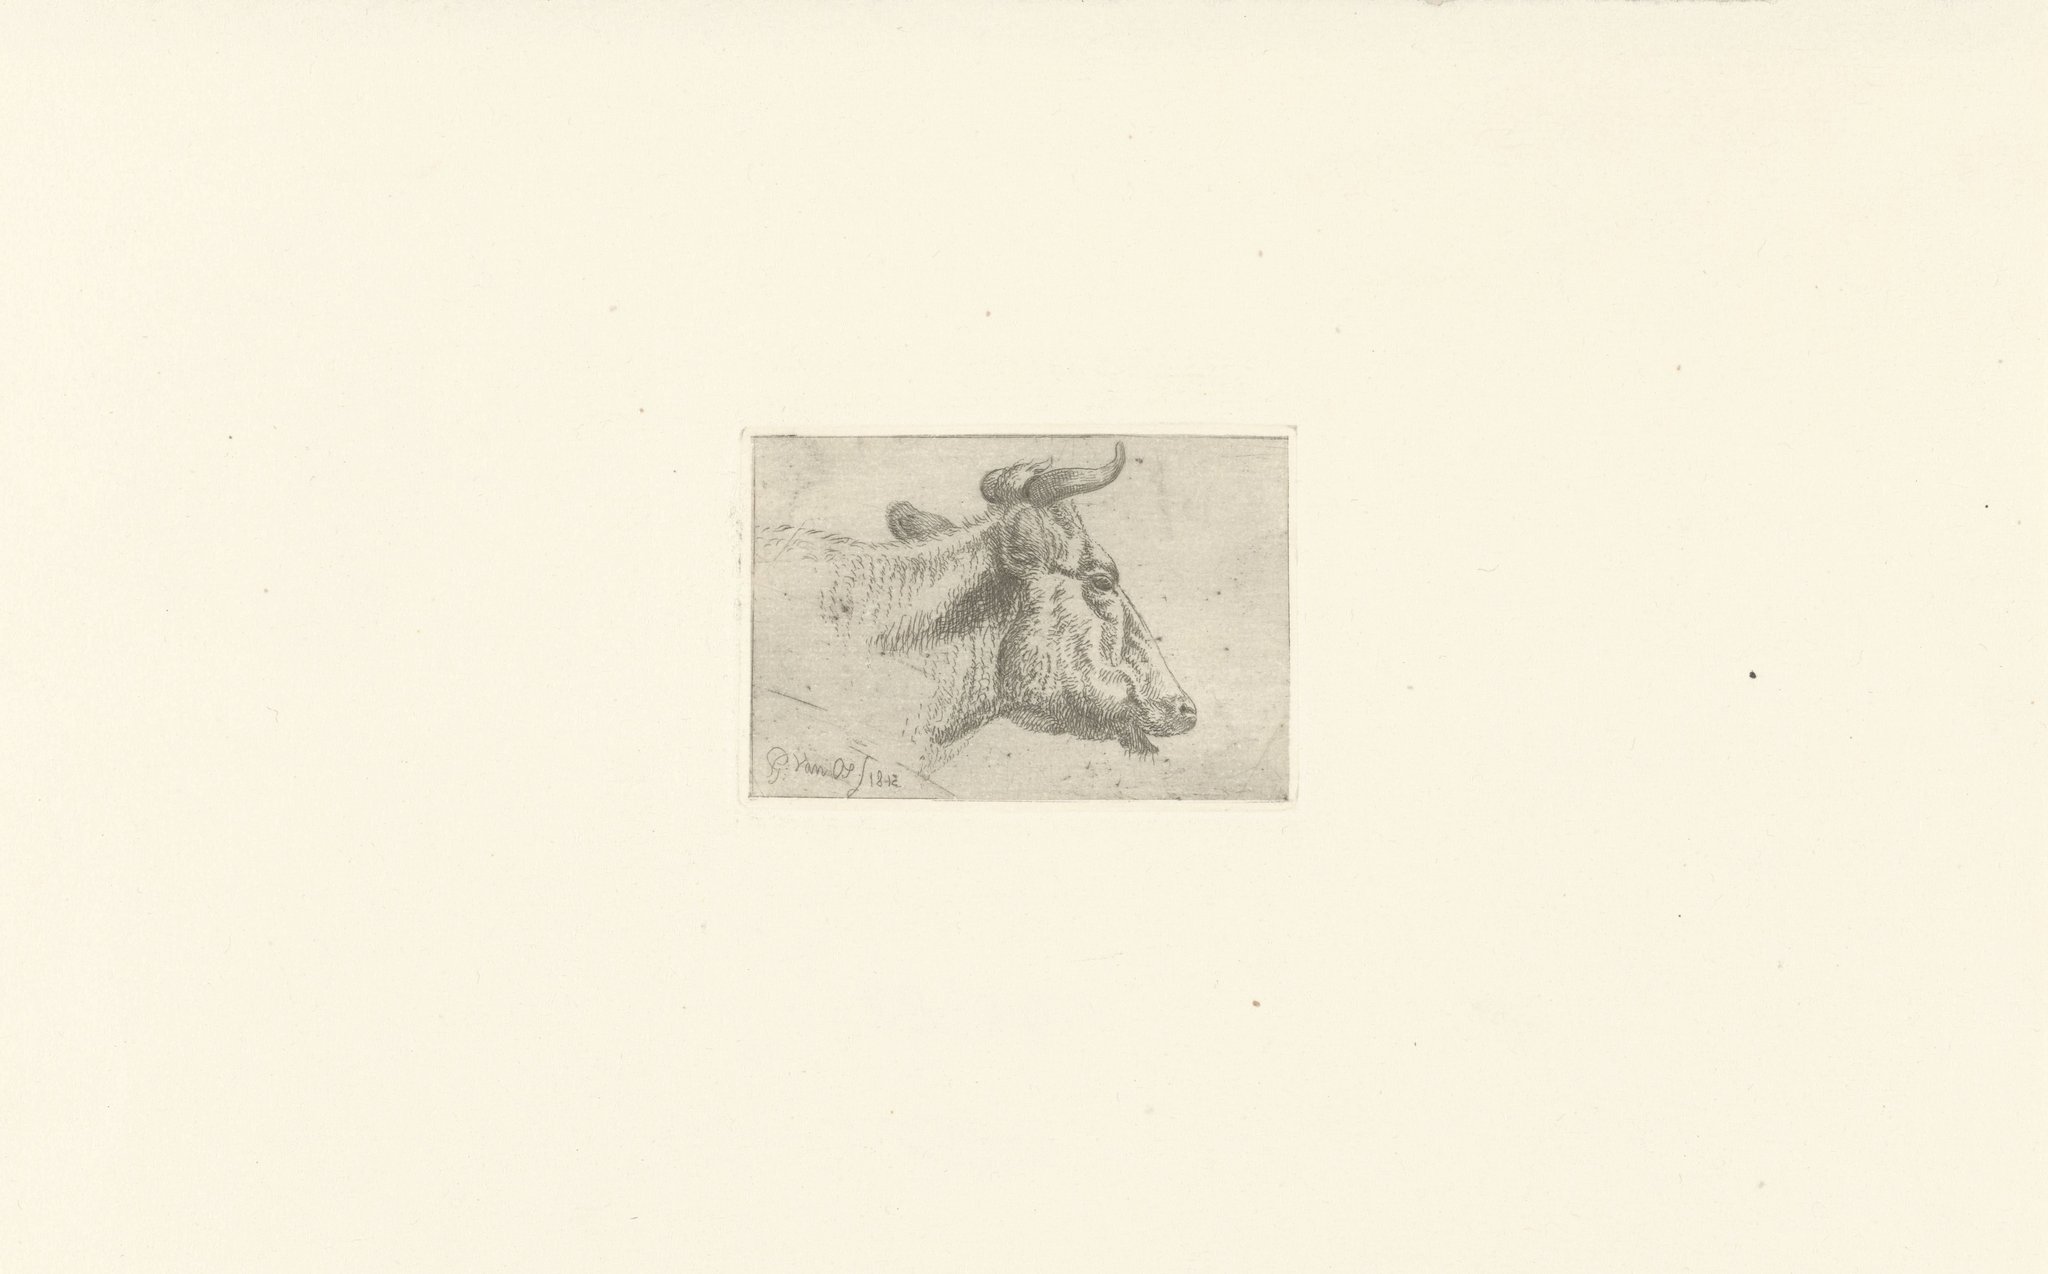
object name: print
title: Koeienkop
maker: pieter gerardus van os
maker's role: draughtsman, painter, print maker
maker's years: 1776-1839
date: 1812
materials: paper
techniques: etching, intaglio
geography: netherlands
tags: cow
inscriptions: collector's mark: Lugt 2228